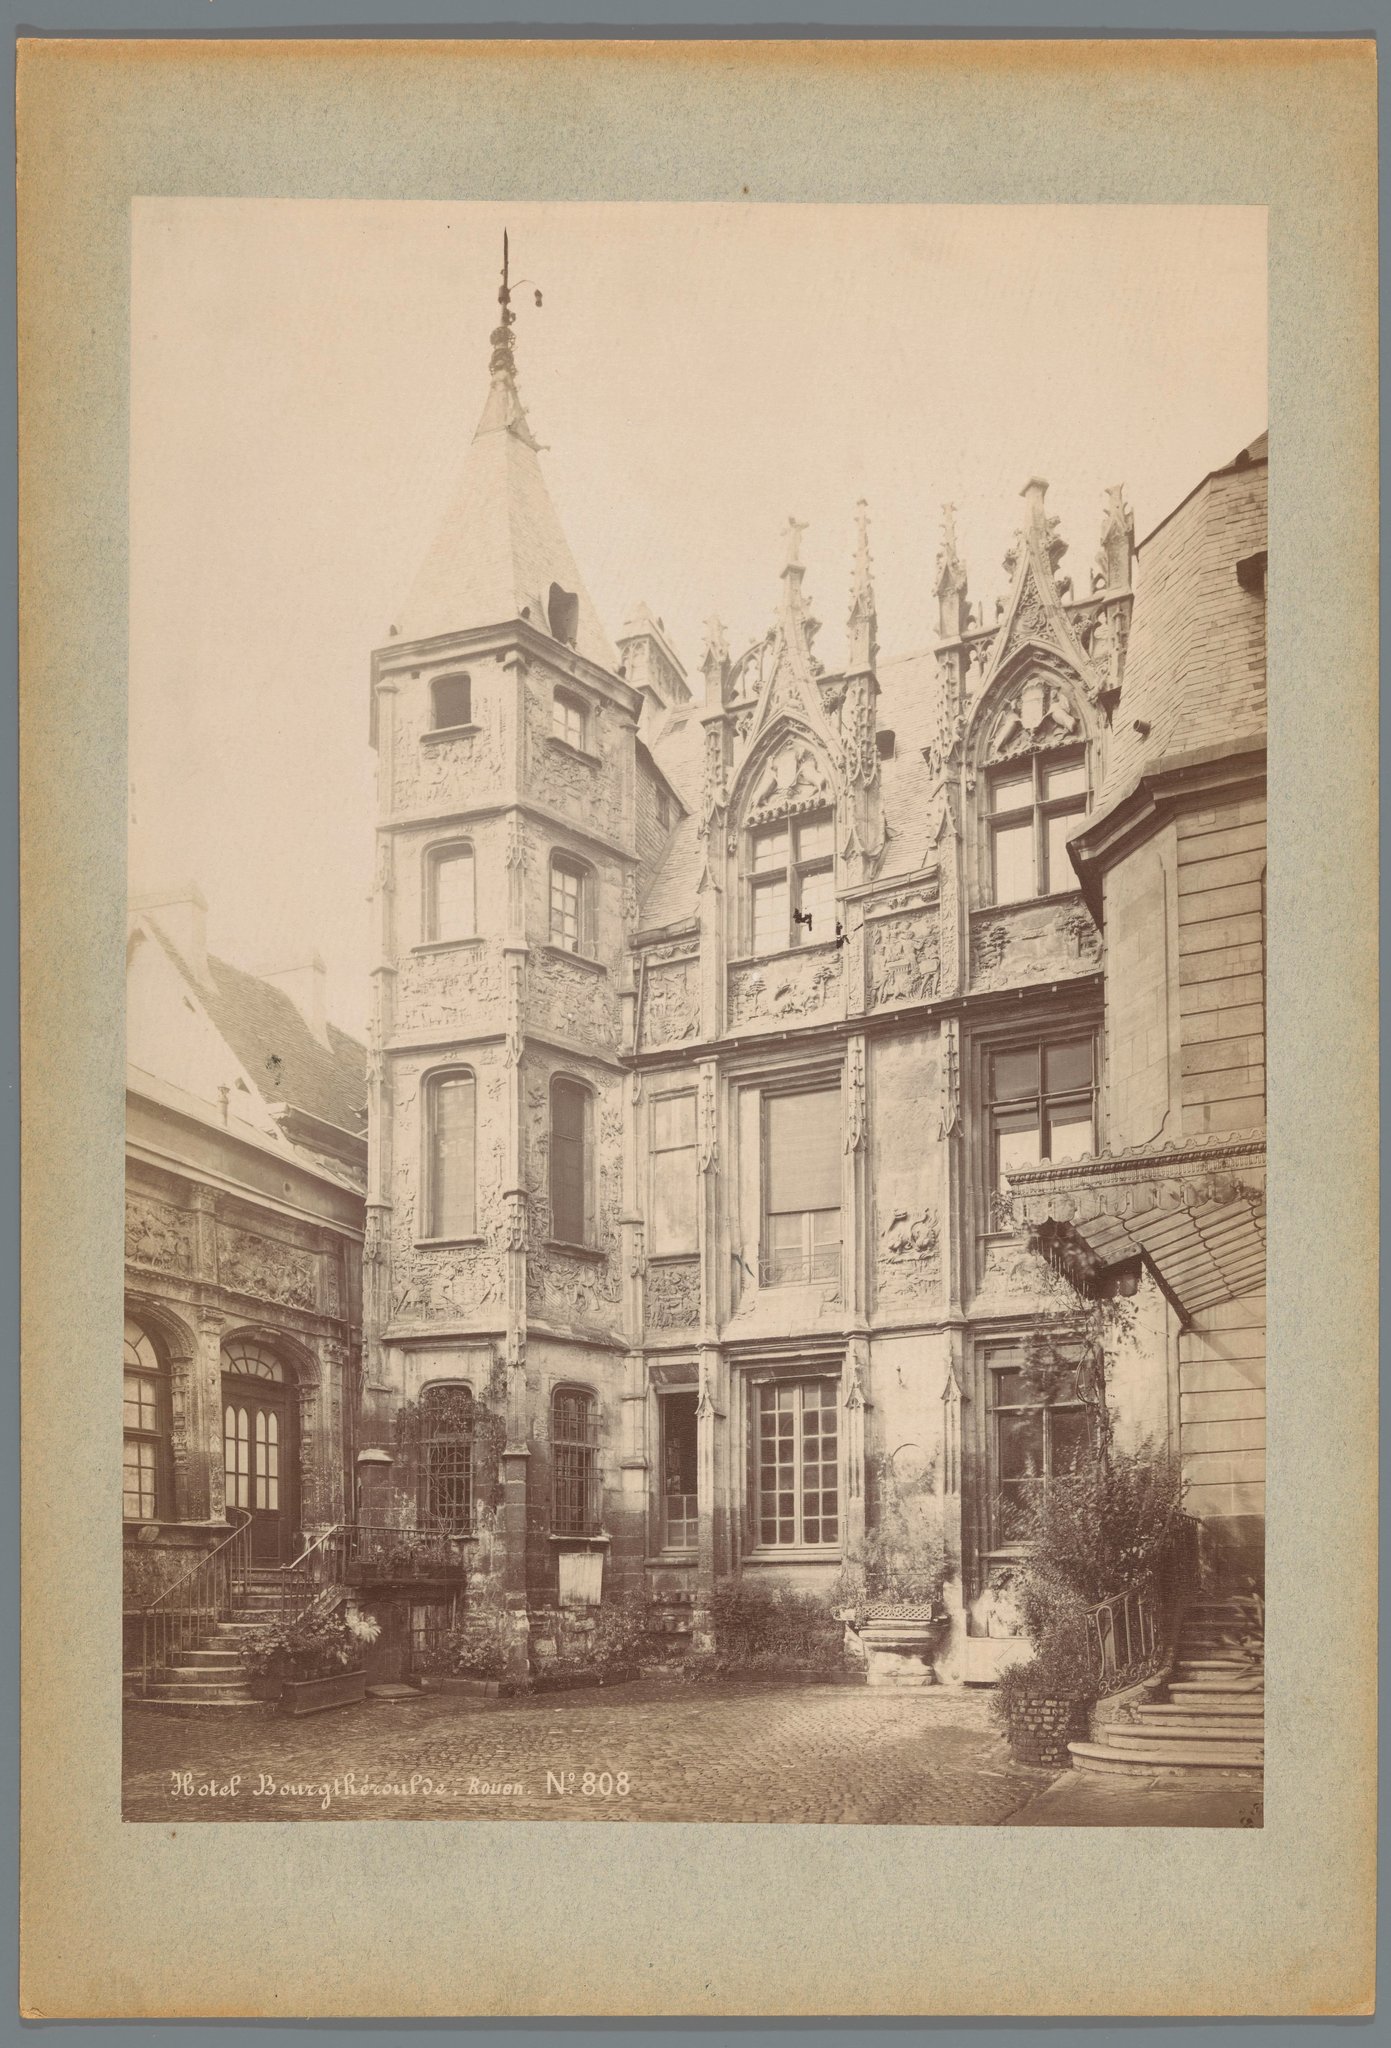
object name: photograph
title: Exterieur van het Hôtel de Bourgtheroulde te Rouen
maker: séraphin-médéric mieusement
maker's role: fotograaf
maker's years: 1840-1905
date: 1875-1900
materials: cardboard, photographic support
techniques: albumen print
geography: rouen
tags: exterior ~ representation of a building, hôtel, i.e. small palace in city, façade (of house or building), sculpture (+ relief ~ sculpture)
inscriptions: collector's mark: Lugt 3937, name: ‘MIEUSEMENT PHOTOGRAPHE’, name: ‘KUNSTBOEKHANDEL J. A. G. DE LEUR PHOTOGRAAF - UITGEVER Huigenspark, 40b. DEN HAAG’, name: ‘MONUMENTS HISTORIQUES’, inscription: ‘X k1 pl 1’, number: ‘No. 808’